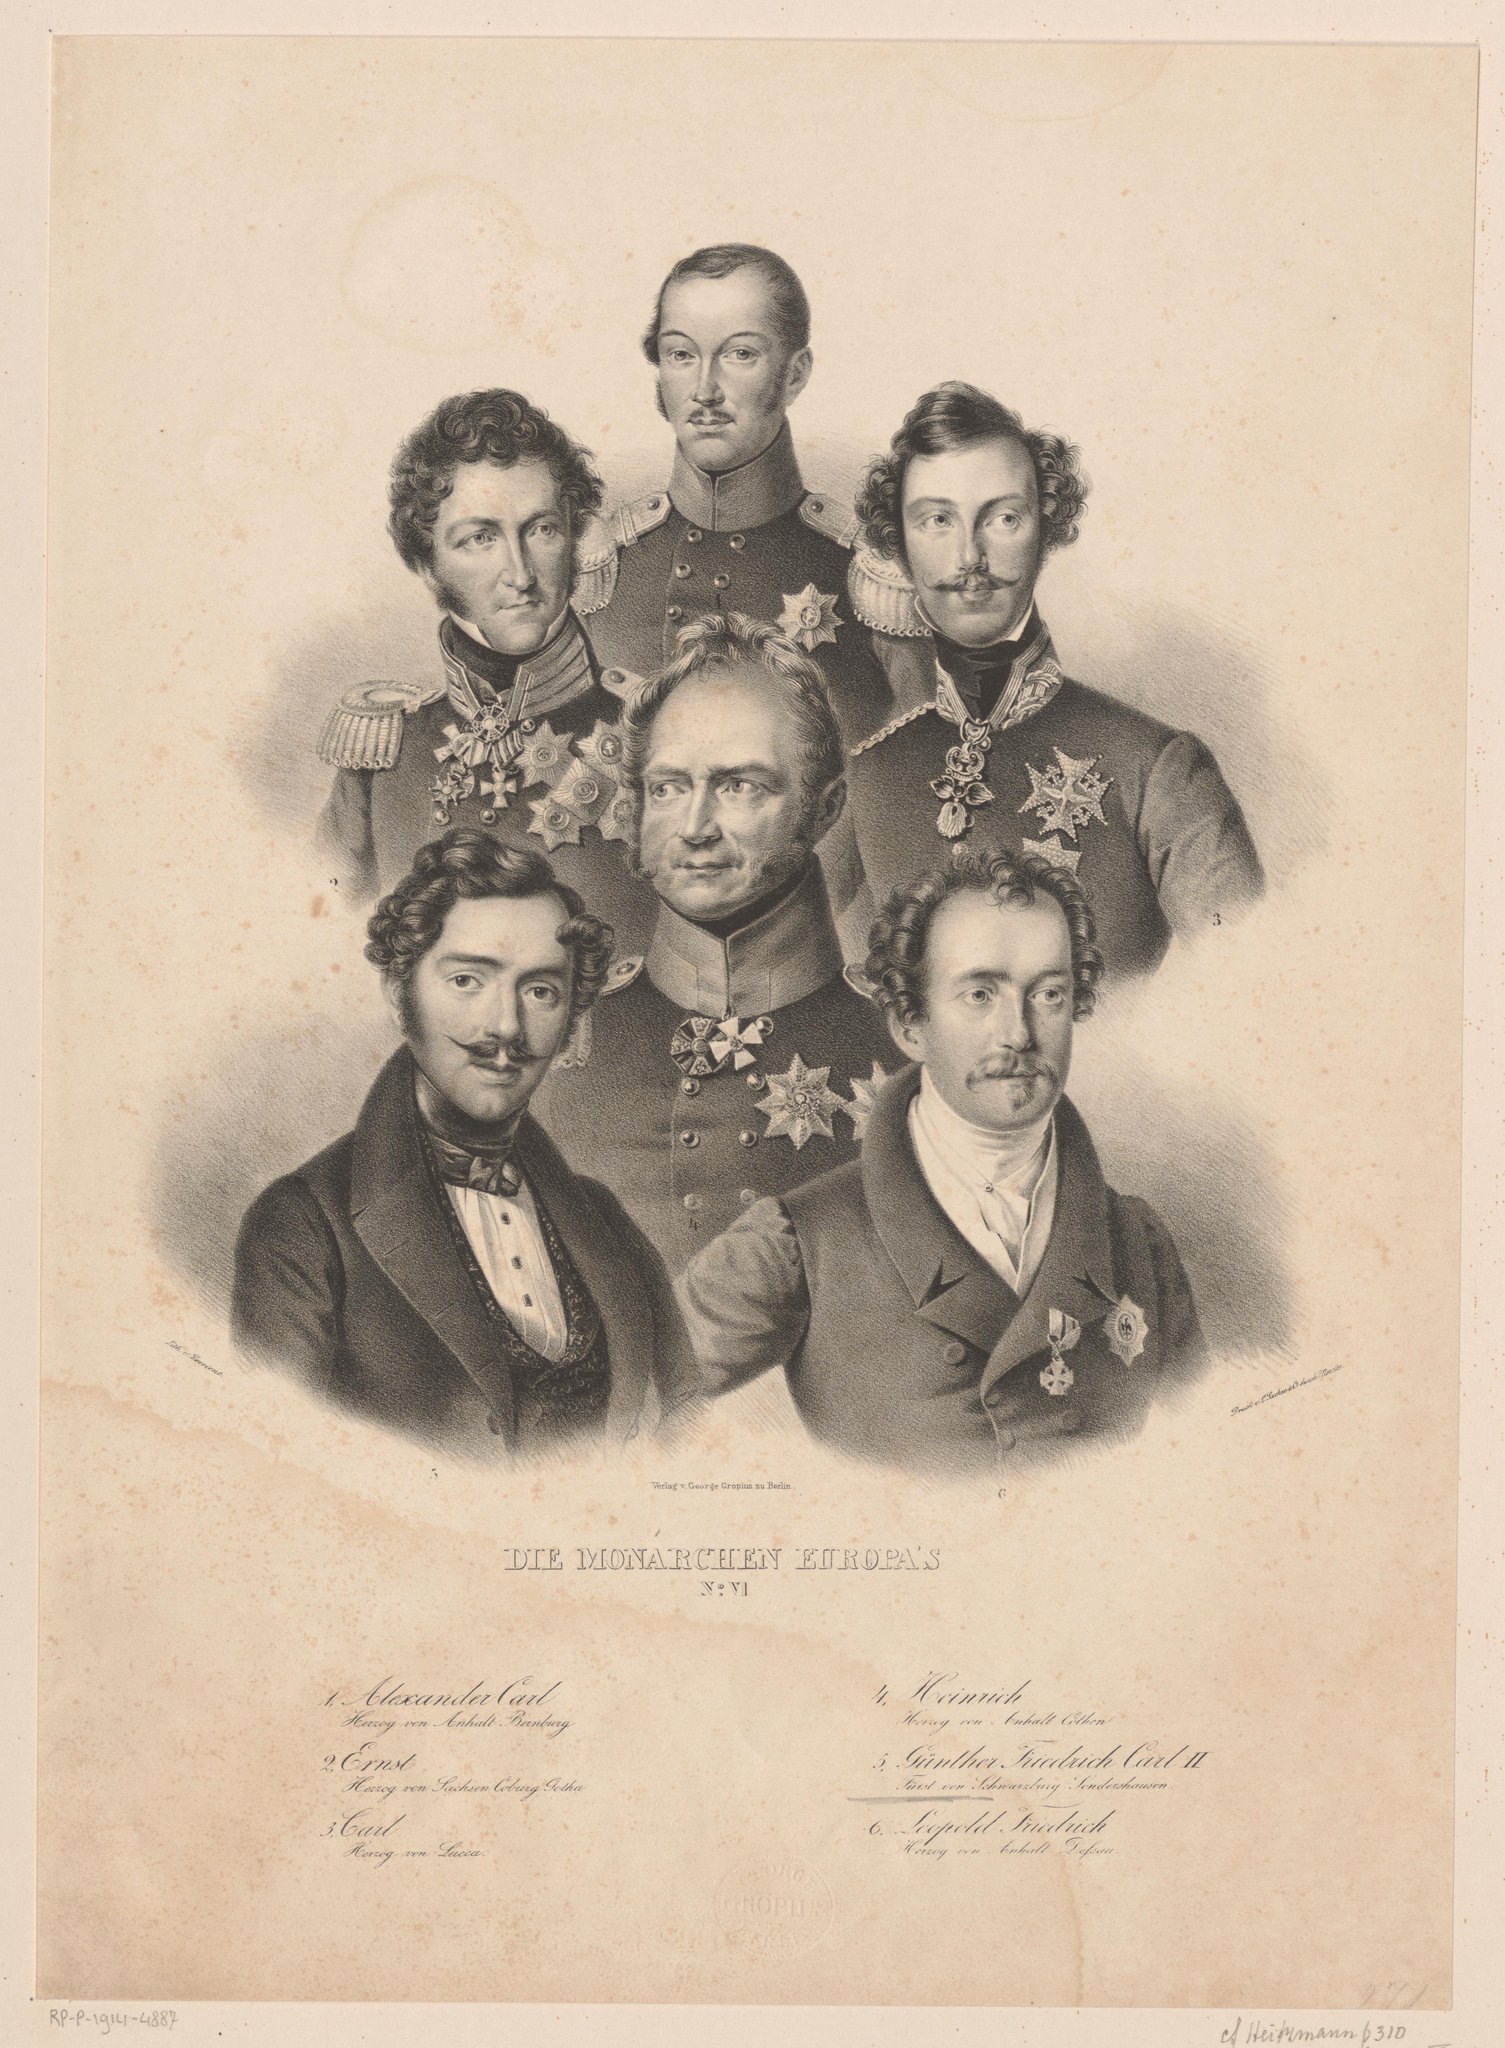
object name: print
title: Portretten van zes vorsten van Europa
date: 1832-1854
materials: paper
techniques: lithograph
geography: berlin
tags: august van oldenburg, willem van brunswijk, historical persons, ruler, sovereign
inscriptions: collector's mark: Lugt 2228, check stamp: Lugt 4221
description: Portretten van Wilhelm August von Braunschweig-Lüneburg, Wilhelm II, keurvorst van Hessen-Kassel, Paul Friedrich groothertog van Mecklenburg-Schwerin, Georg von Mecklenburg-Strelitz, August van Oldenburg en Willem van Nassau.